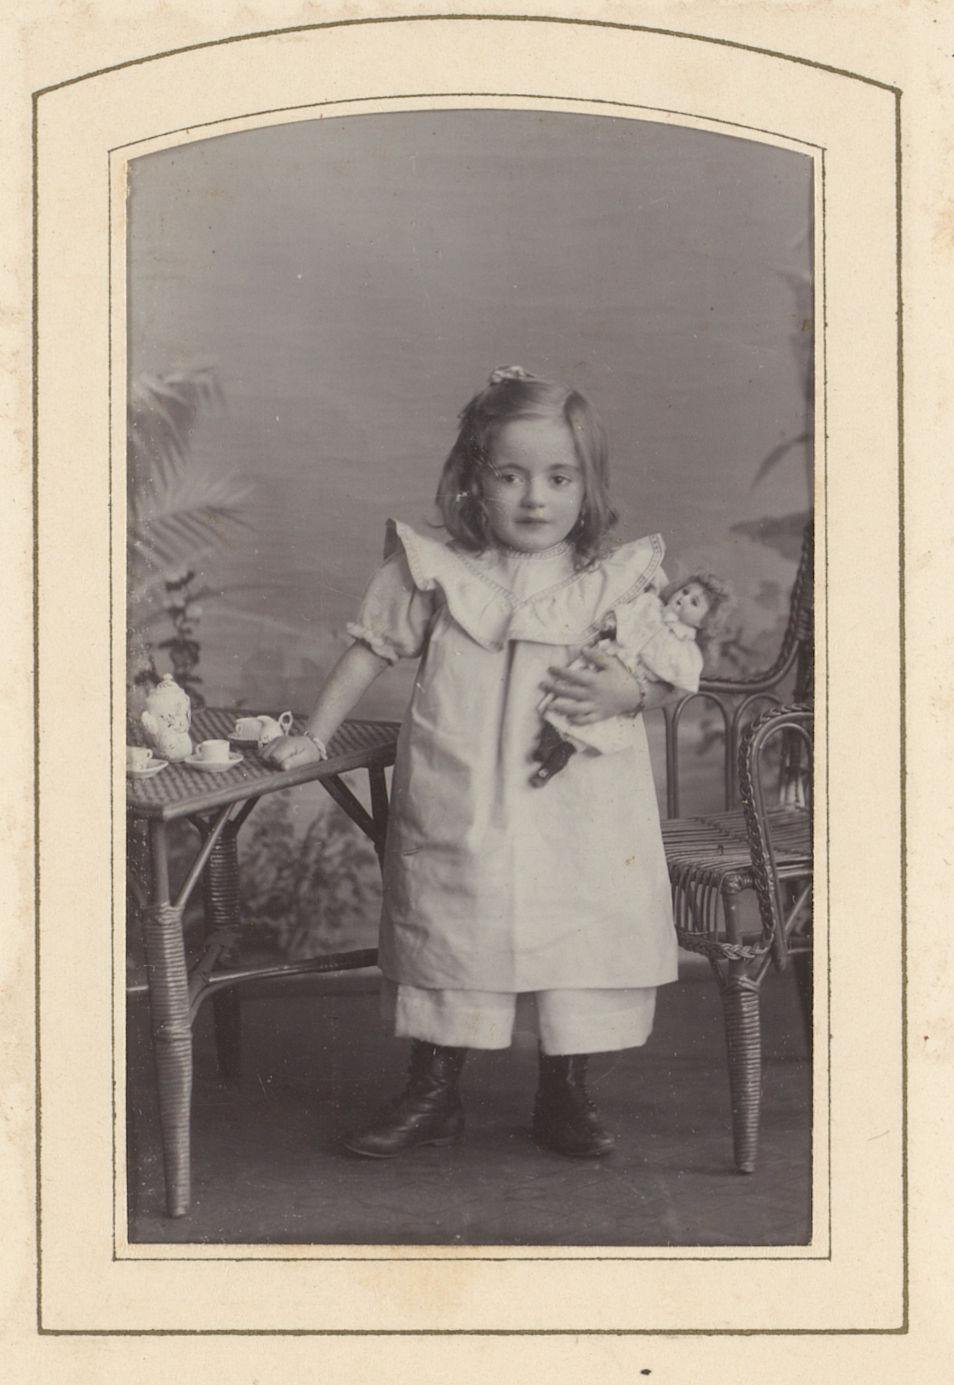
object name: photograph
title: Portret van een meisje met pop in de hand, staand bij een tafel met theeservies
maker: max cosman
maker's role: fotograaf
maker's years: 1852-1894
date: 1881-1903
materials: cardboard, photographic support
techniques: collodion silver print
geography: amsterdam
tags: historical persons - bb - woman, (playing with) dolls, toddler (female)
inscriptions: inscription: ‘Max Cosman/ Hofphotograaf/ Amsterdam/ Galerij 48./ Filiaal: Bad Kleef./ Specialiteit/ in/ Vergrootingen. Kooldruk Onveranderlijk./ De plaat blijft voor nabestelling bewaard.’